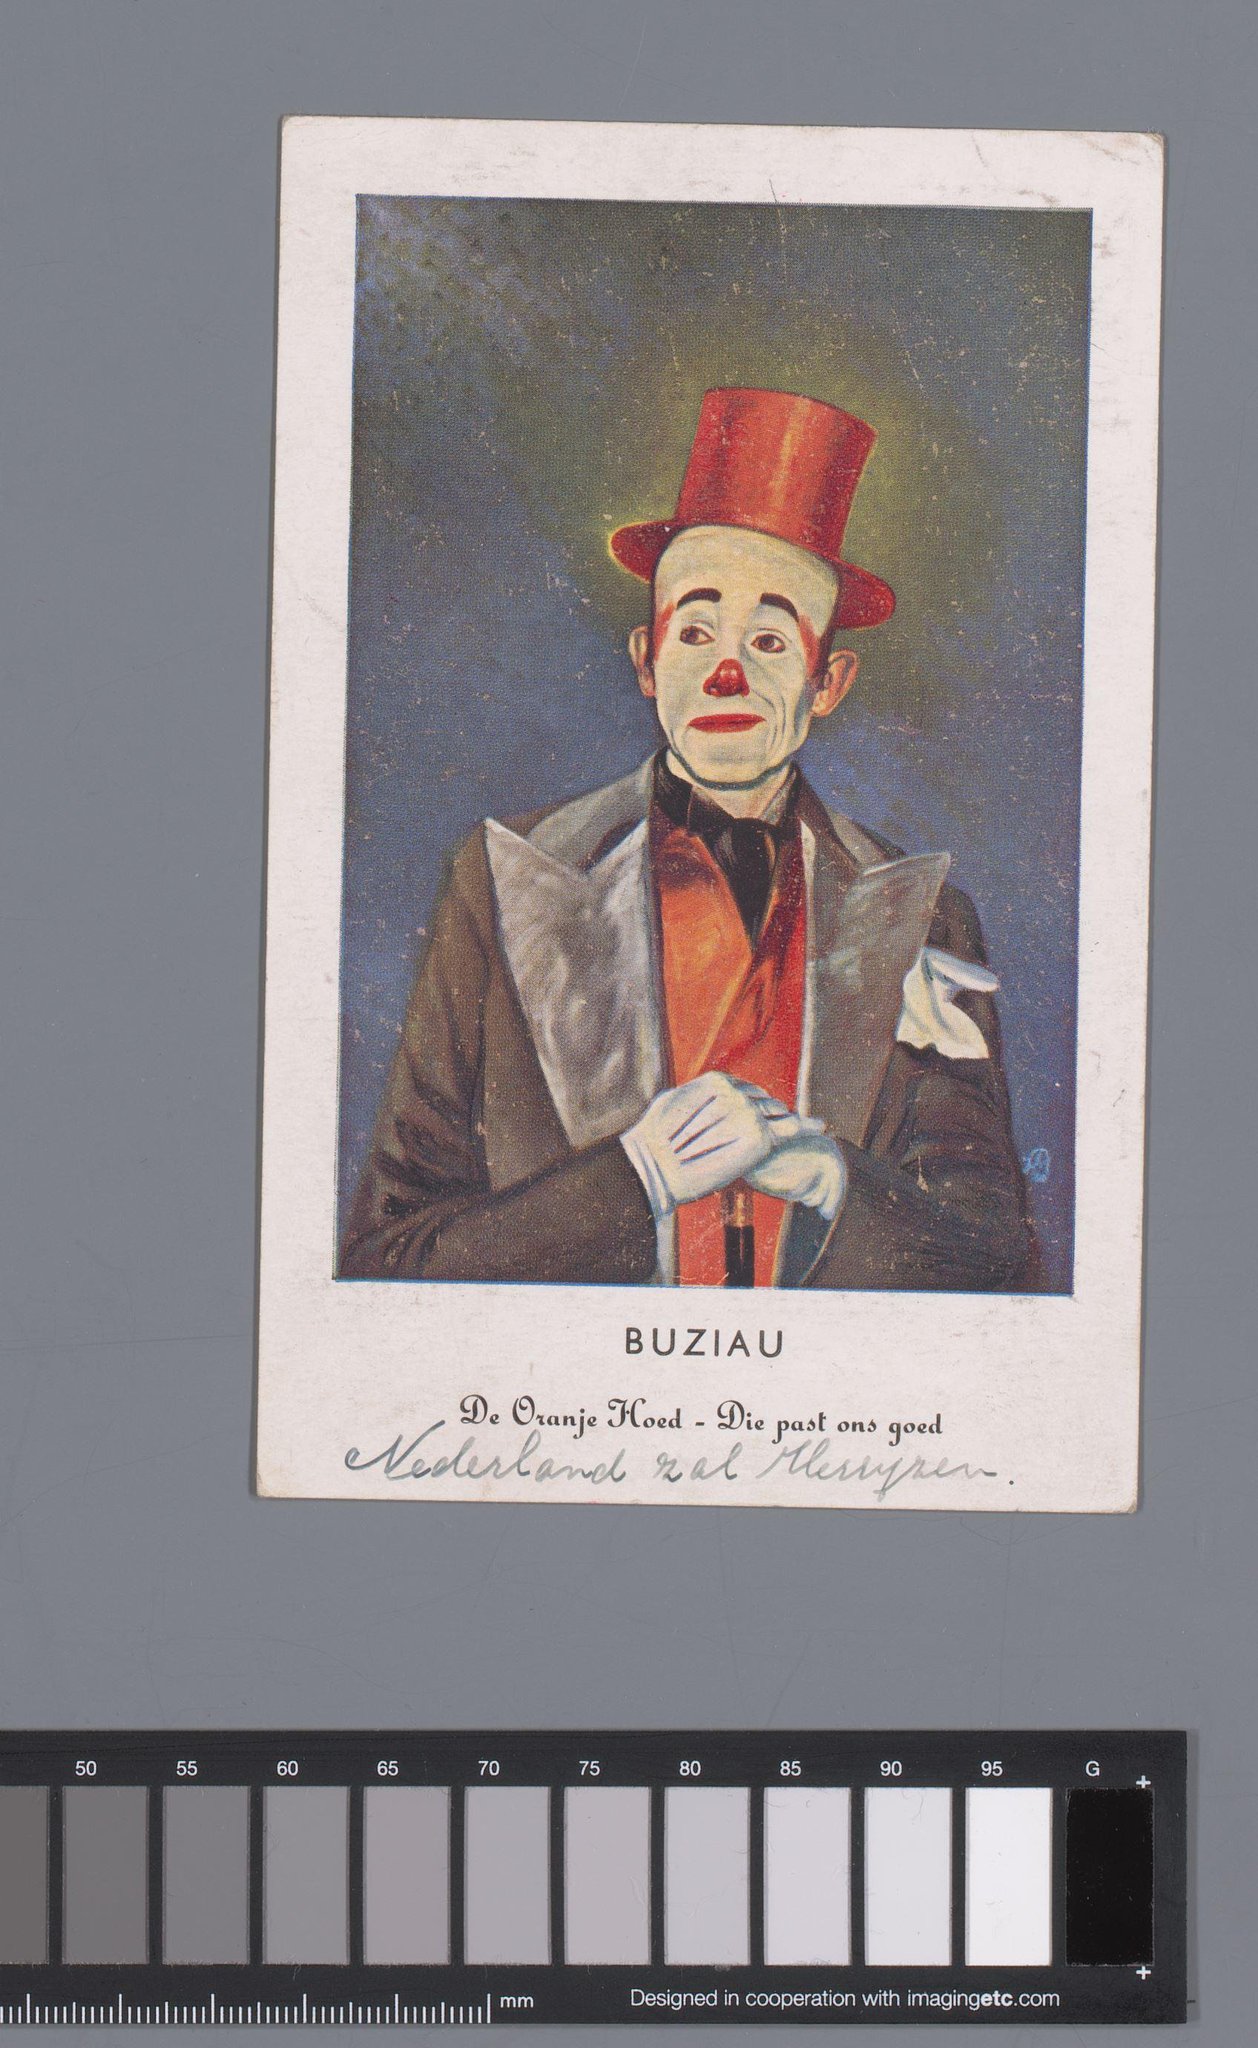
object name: postcard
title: BUZIAU De Oranje Hoed - Die past ons goed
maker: els schreuder peters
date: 1912-1940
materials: ink, paper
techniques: printing, writing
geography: bandung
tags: indië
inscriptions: date